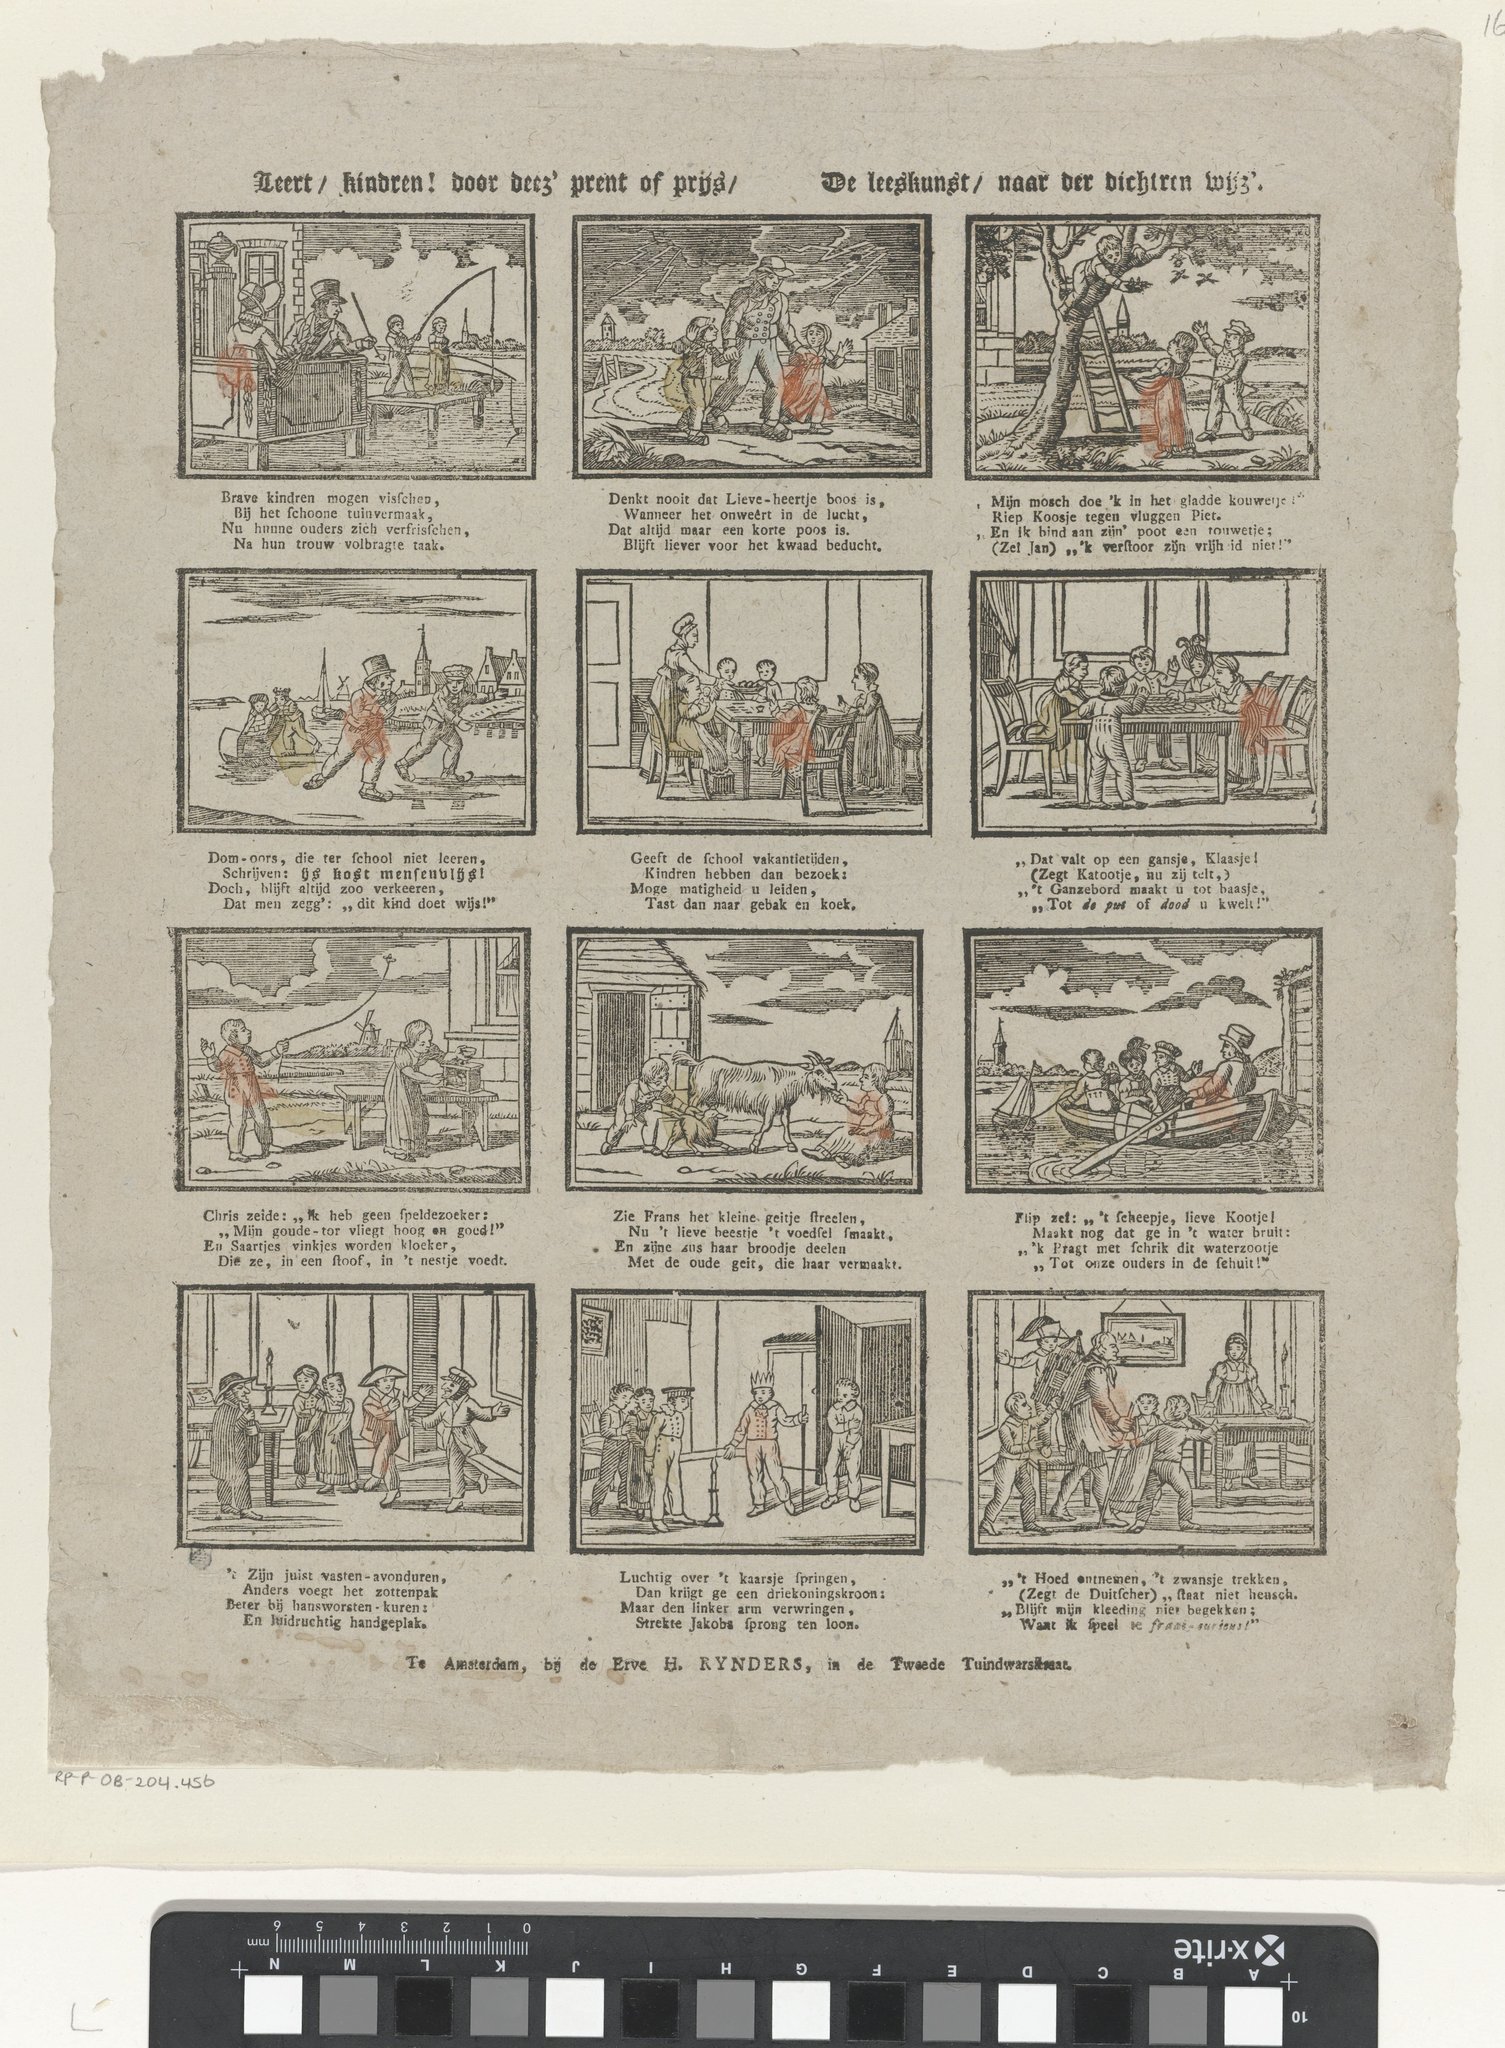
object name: popular print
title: Leert / kindren! door deez' prent of prijs / De leeskunst / naar der dichtren wijs'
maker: Anonymous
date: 1831-1854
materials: paper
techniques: colour, letterpress printing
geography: amsterdam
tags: children's games and plays, rowing facing backward, pulling, child playing with animals, fishing (sports)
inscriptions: collector's mark: Lugt 2760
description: Blad met 12 voorstellingen van kinderspelen en bezigheden, zoals vissen, schaatsen en roeien. Onder elke voorstelling een vierregelig vers.